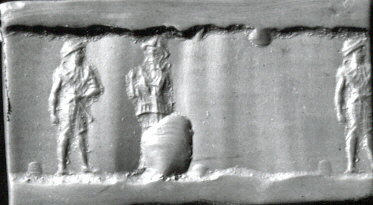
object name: cylinder seal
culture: babylonian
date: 1900-1501 BCE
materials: quartz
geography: mesopotamia